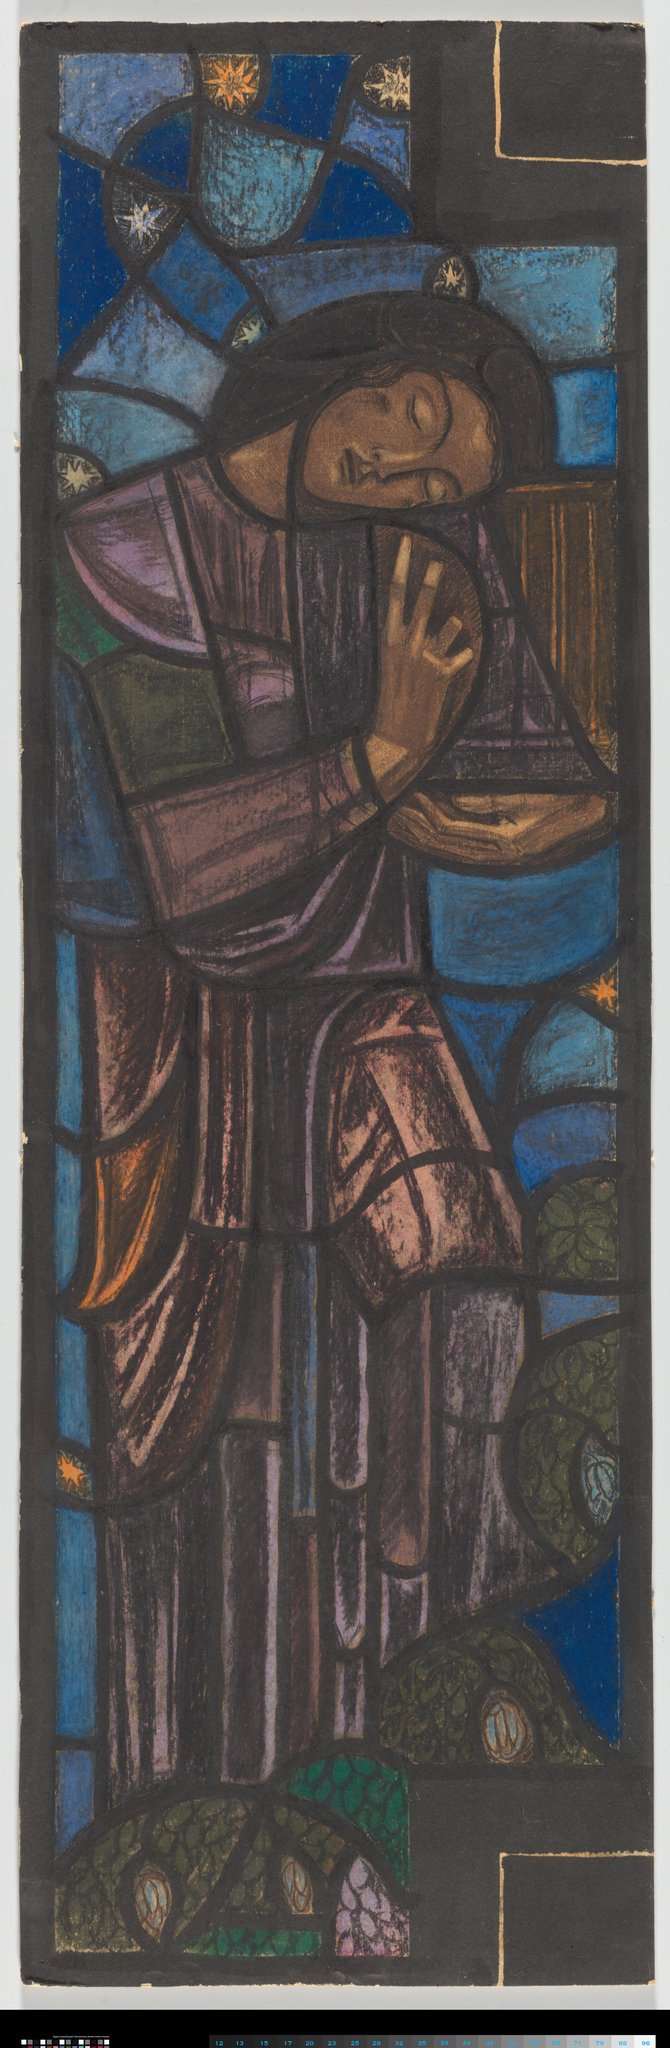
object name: drawing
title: Ontwerp voor raam in het Nederlands Paviljoen op de tentoonstelling Arts Décoratifs te Parijs, 1925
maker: richard nicolaüs roland holst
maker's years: 1868-1938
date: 1925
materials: cardboard, chalk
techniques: brush